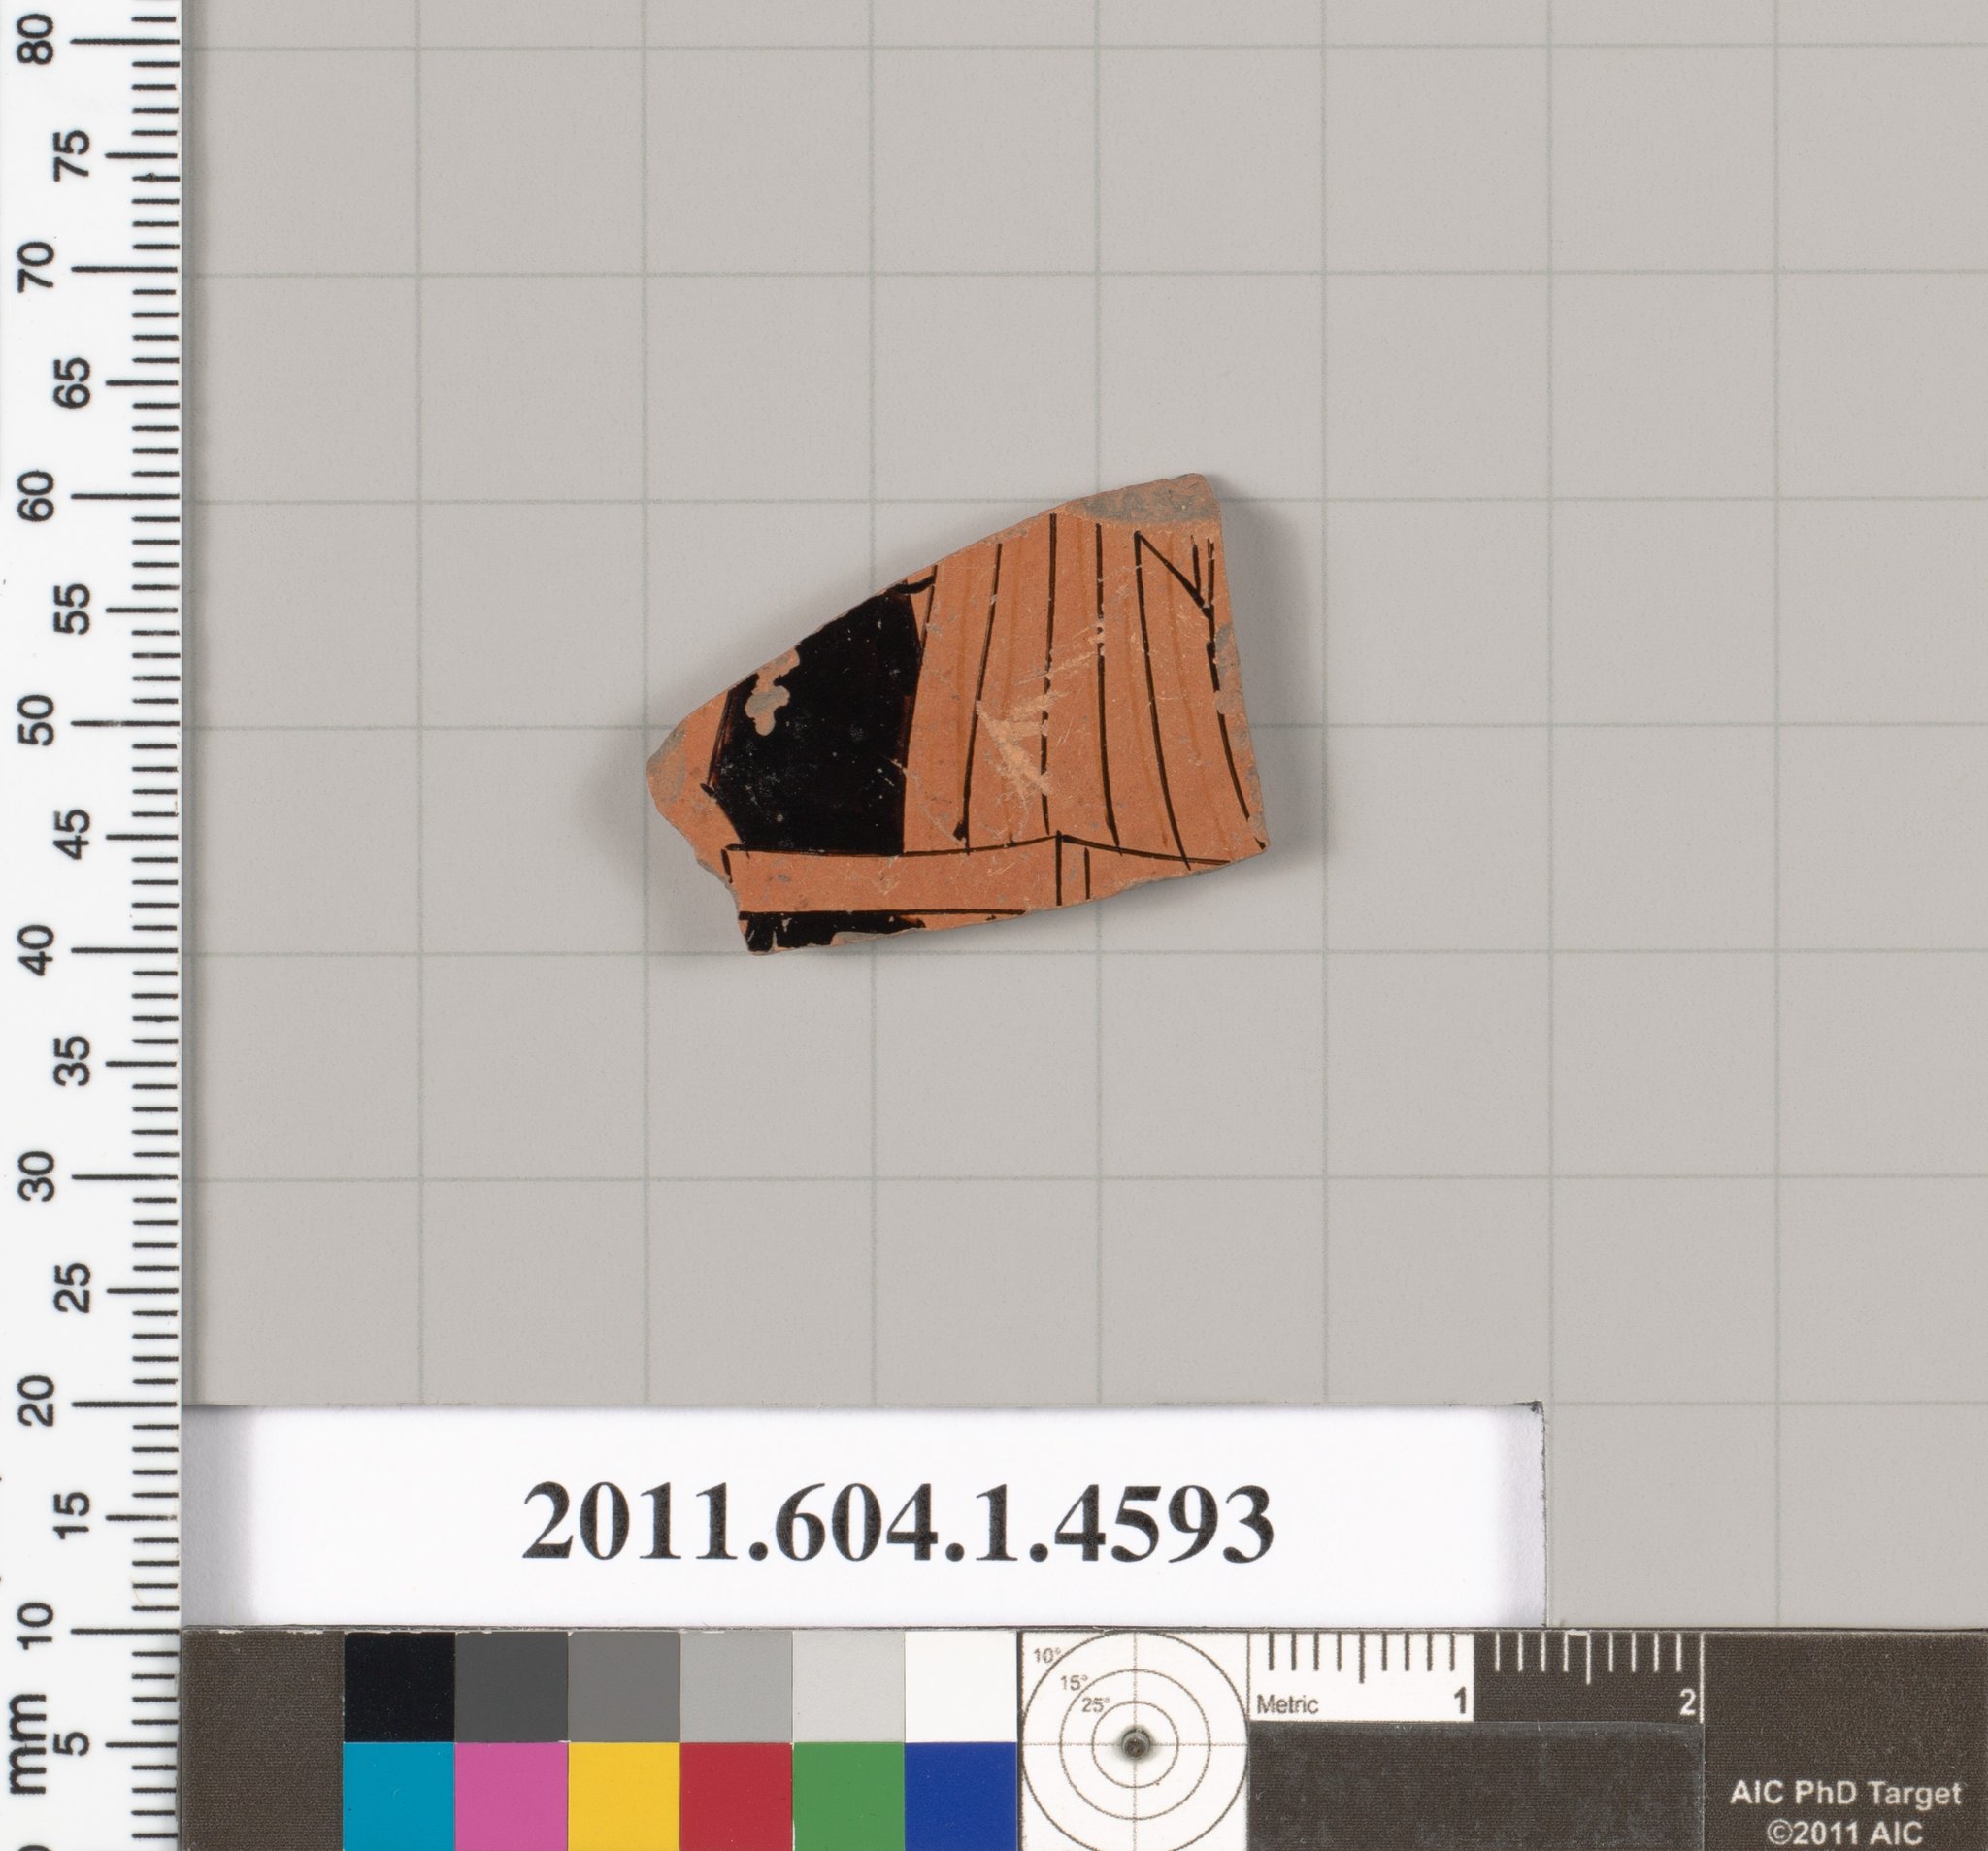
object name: kylix fragment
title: Terracotta fragment of a kylix (drinking cup)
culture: greek, attic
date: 480-470 BCE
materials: terracotta